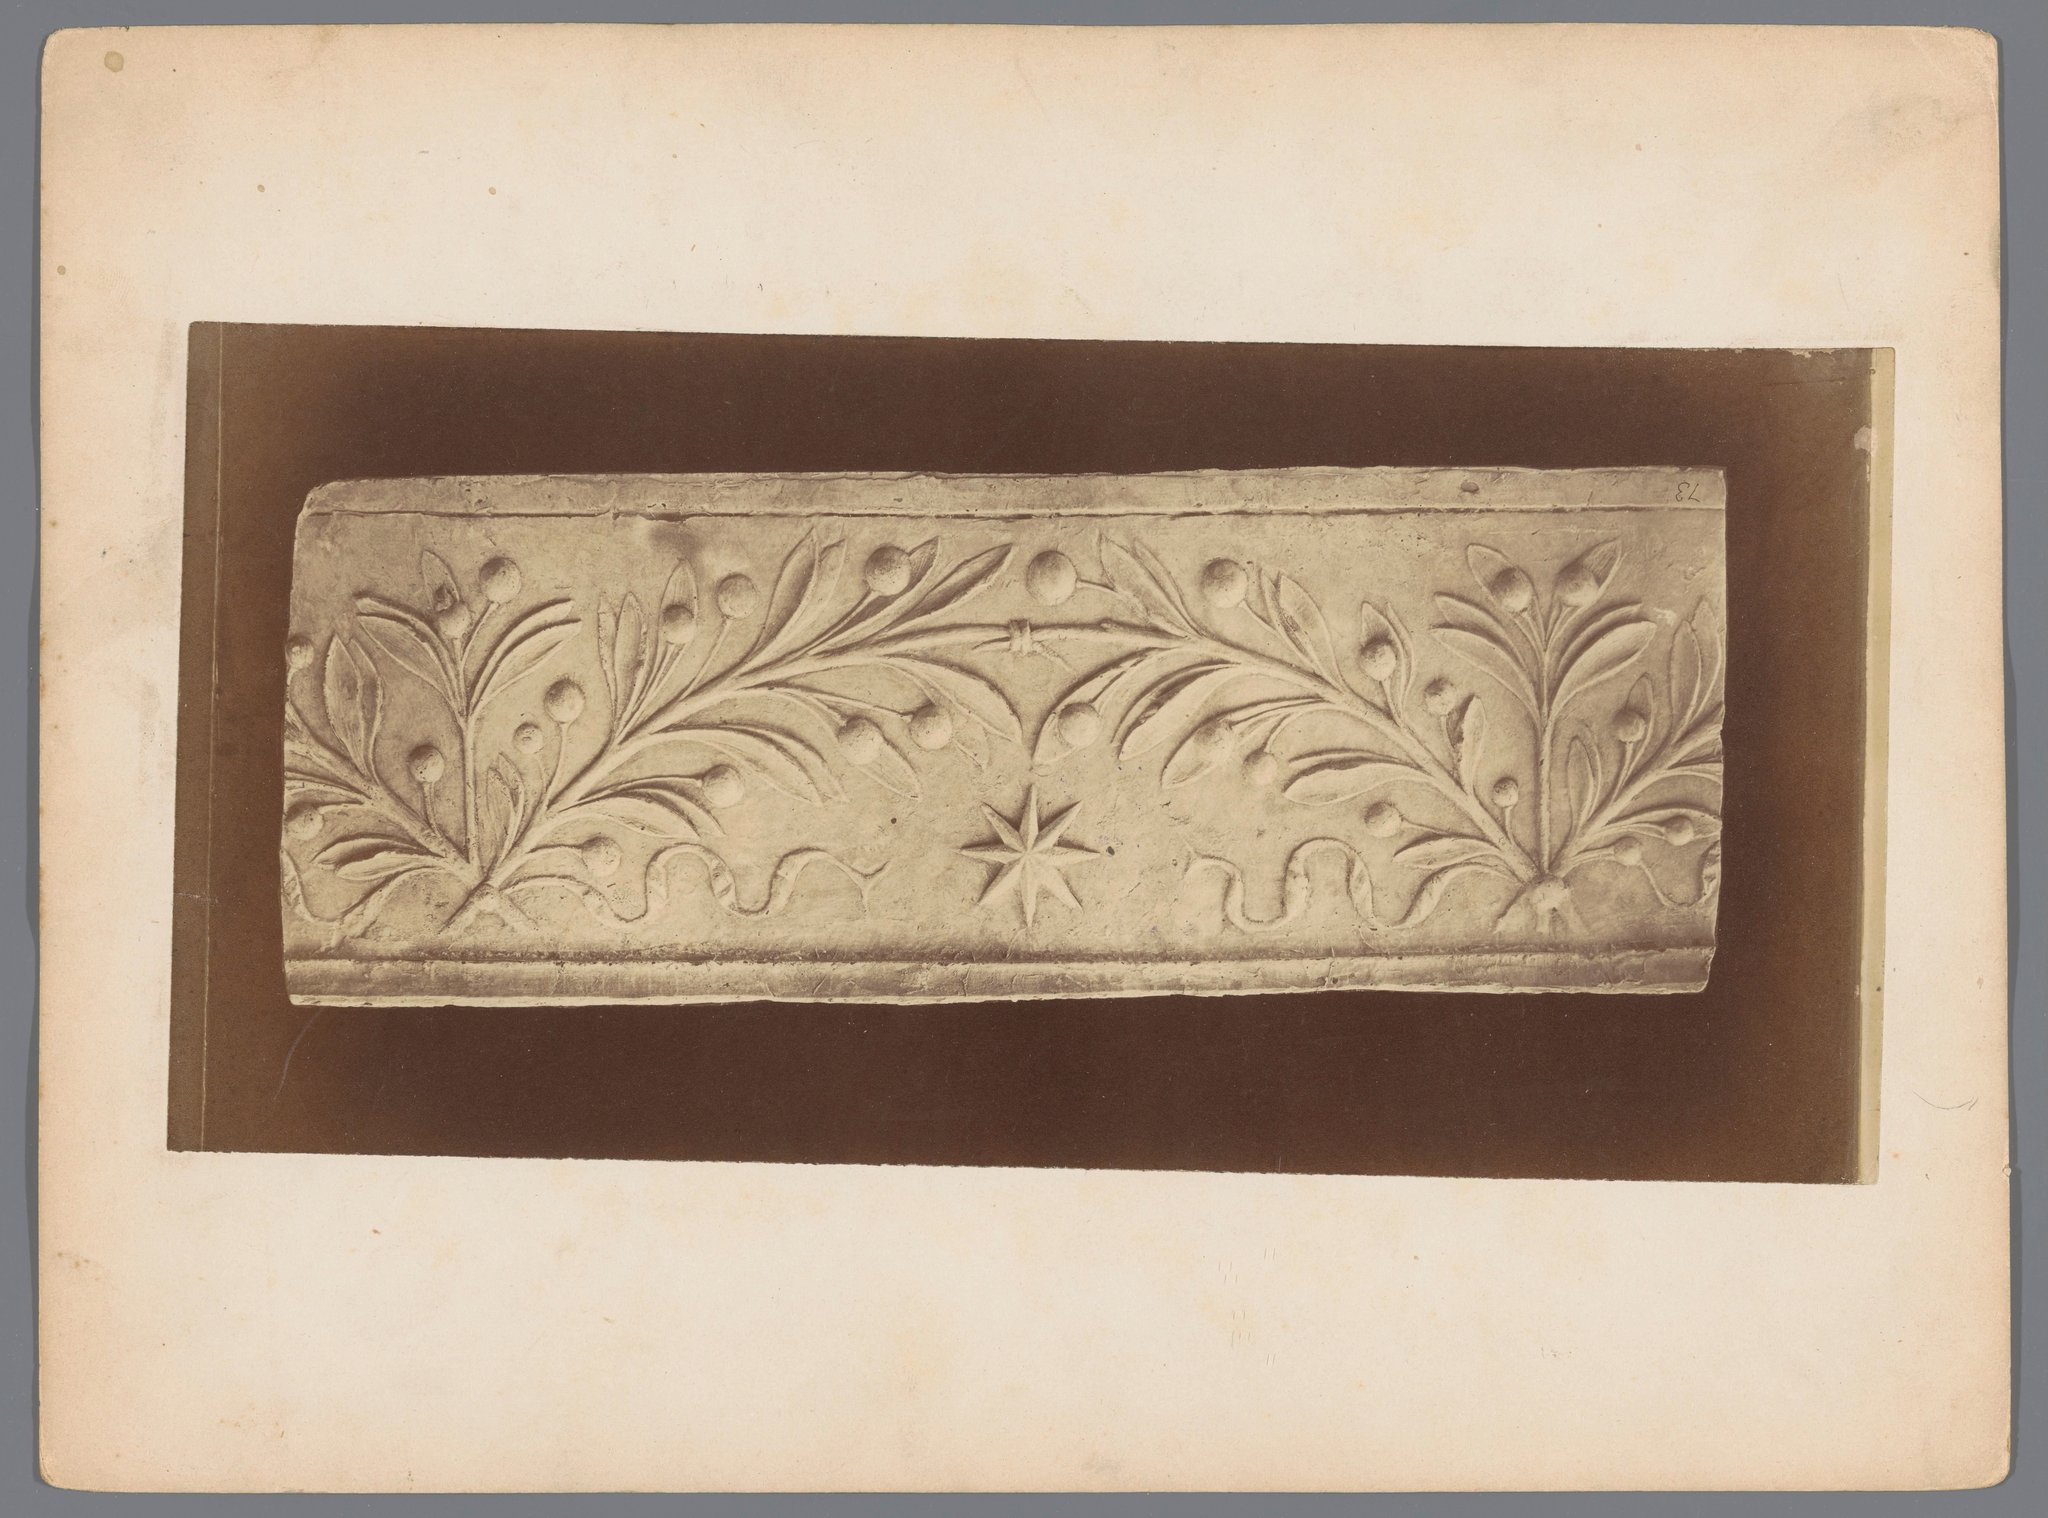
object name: photograph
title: Reliëf met bladmotief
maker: gustave eugène chauffourier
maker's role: fotograaf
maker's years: 1845-1919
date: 1875-1900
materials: photographic support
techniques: albumen print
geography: italy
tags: foliage, tendrils, branches ~ ornament, sculpture (+ relief ~ sculpture)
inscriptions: collector's mark: Lugt 3937, number: ‘73’